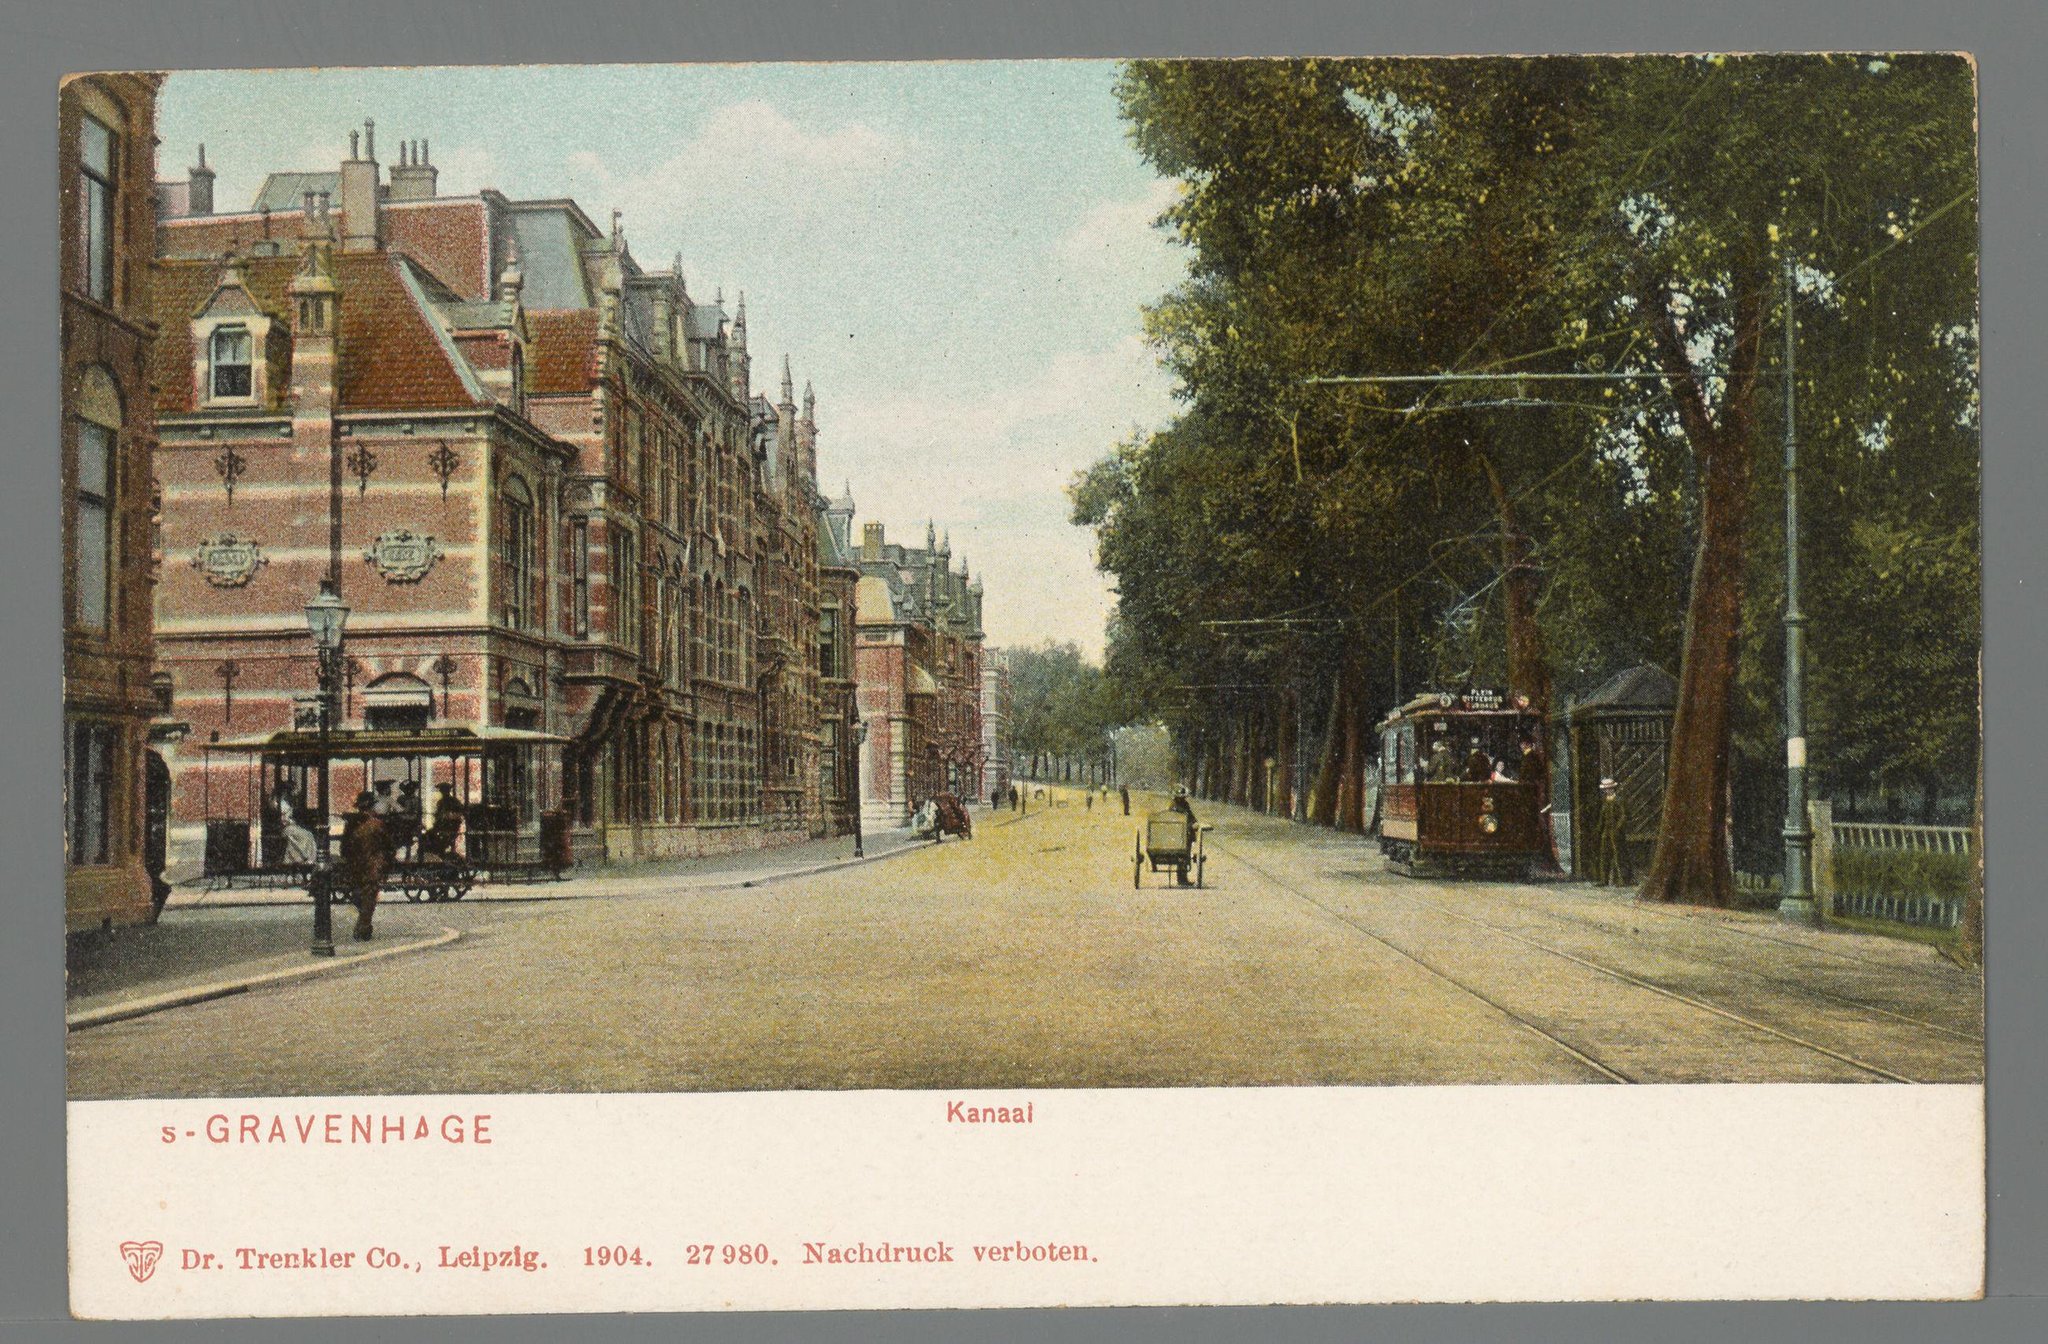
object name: photomechanical print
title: s-Gravenhage. Kanaal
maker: Anonymous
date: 1904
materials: cardboard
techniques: lithograph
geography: leipzig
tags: tram, street, the hague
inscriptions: date